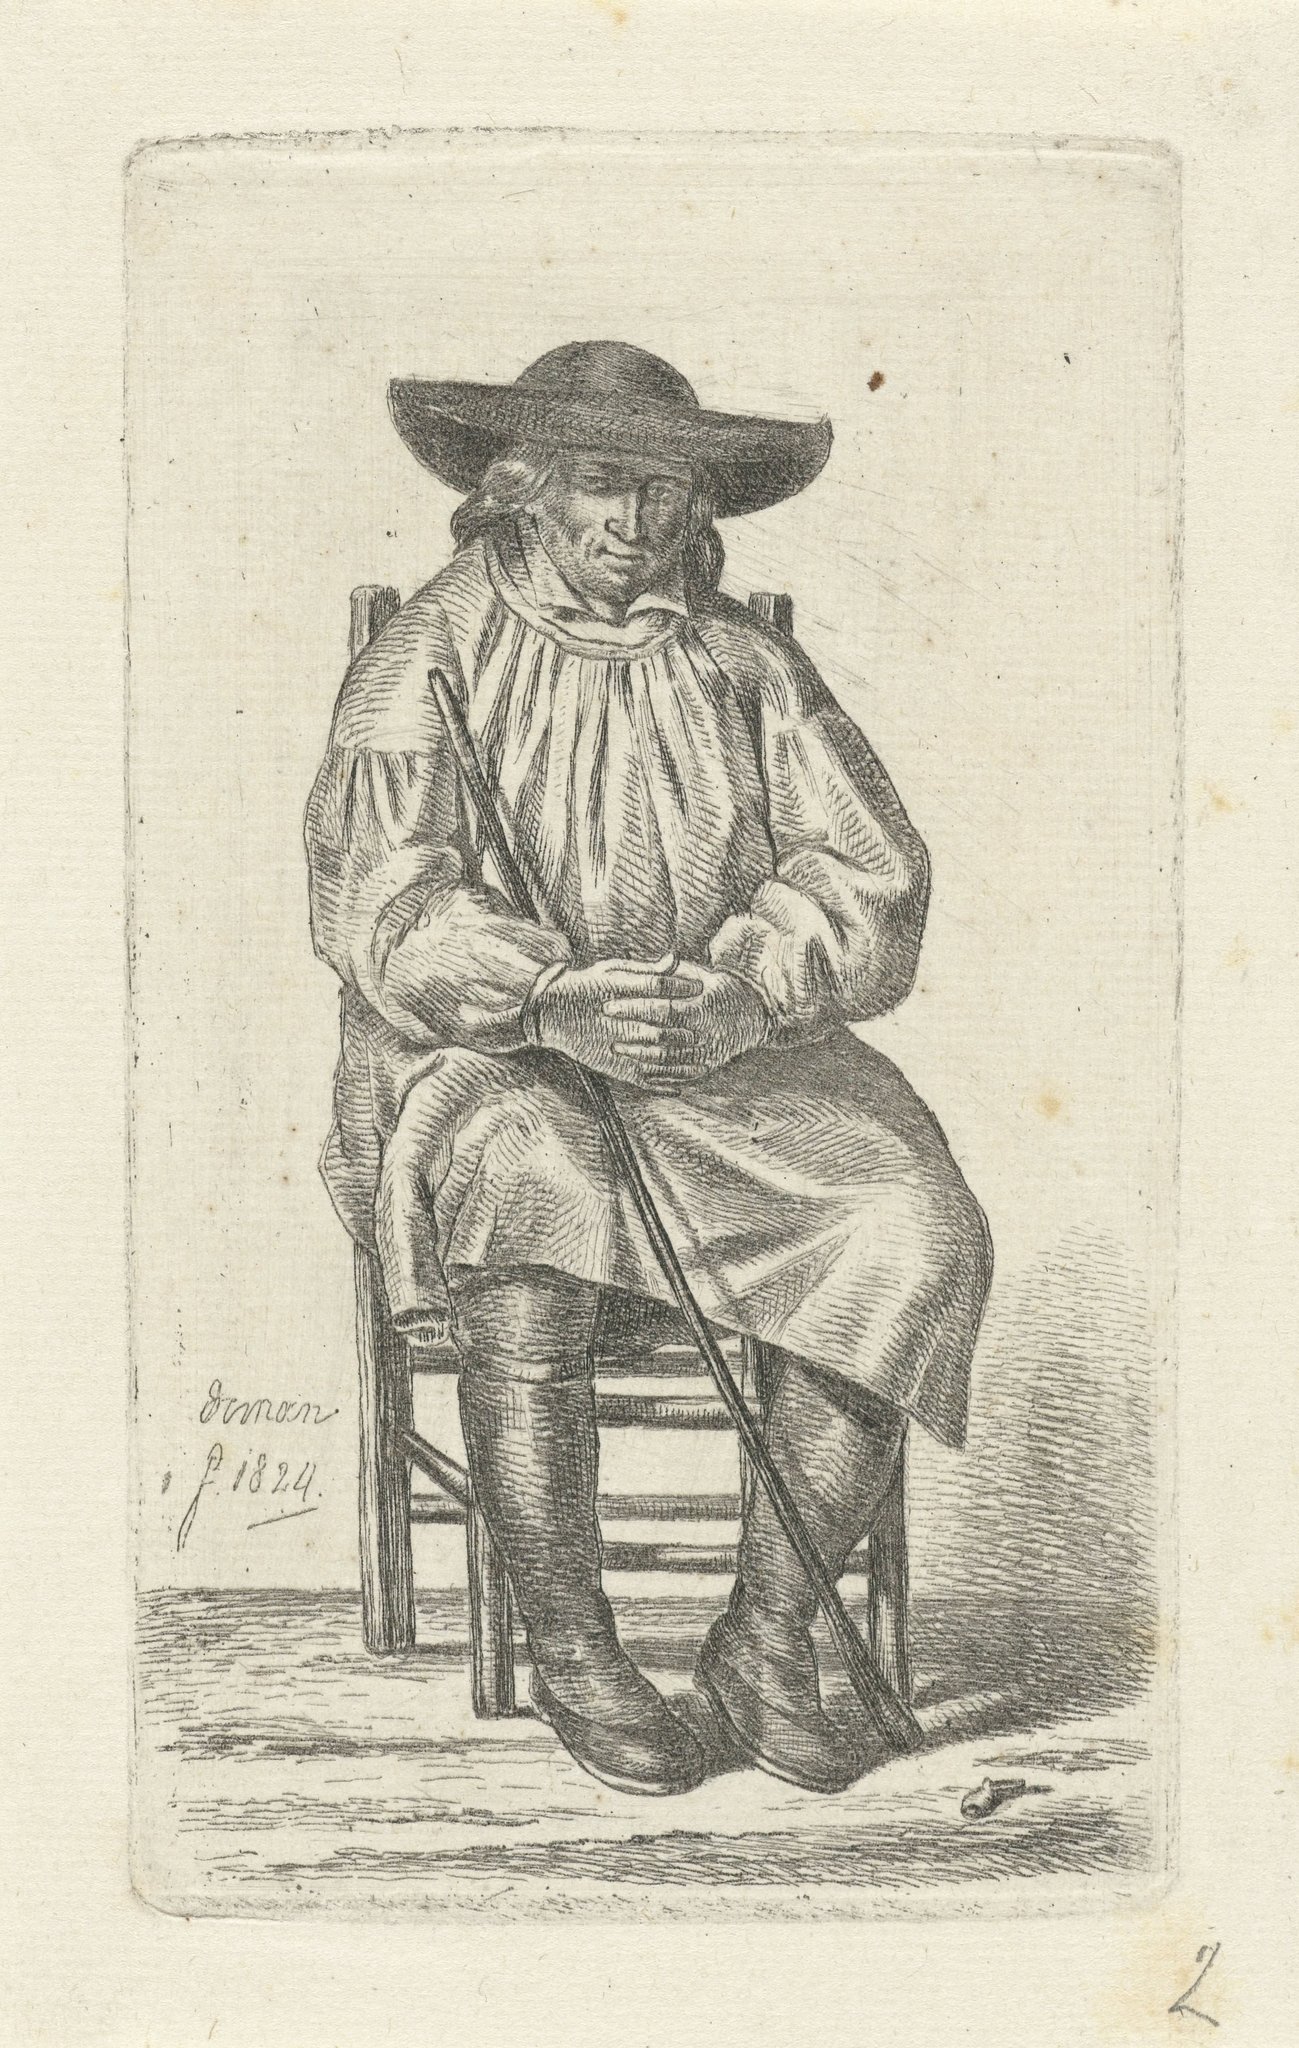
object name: print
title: Zittende man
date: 1824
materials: paper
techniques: etching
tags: sitting figure, chair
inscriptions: collector's mark: Lugt 2228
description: Zittende man met stok, voor hem op de grond een klein pijpenkopje.